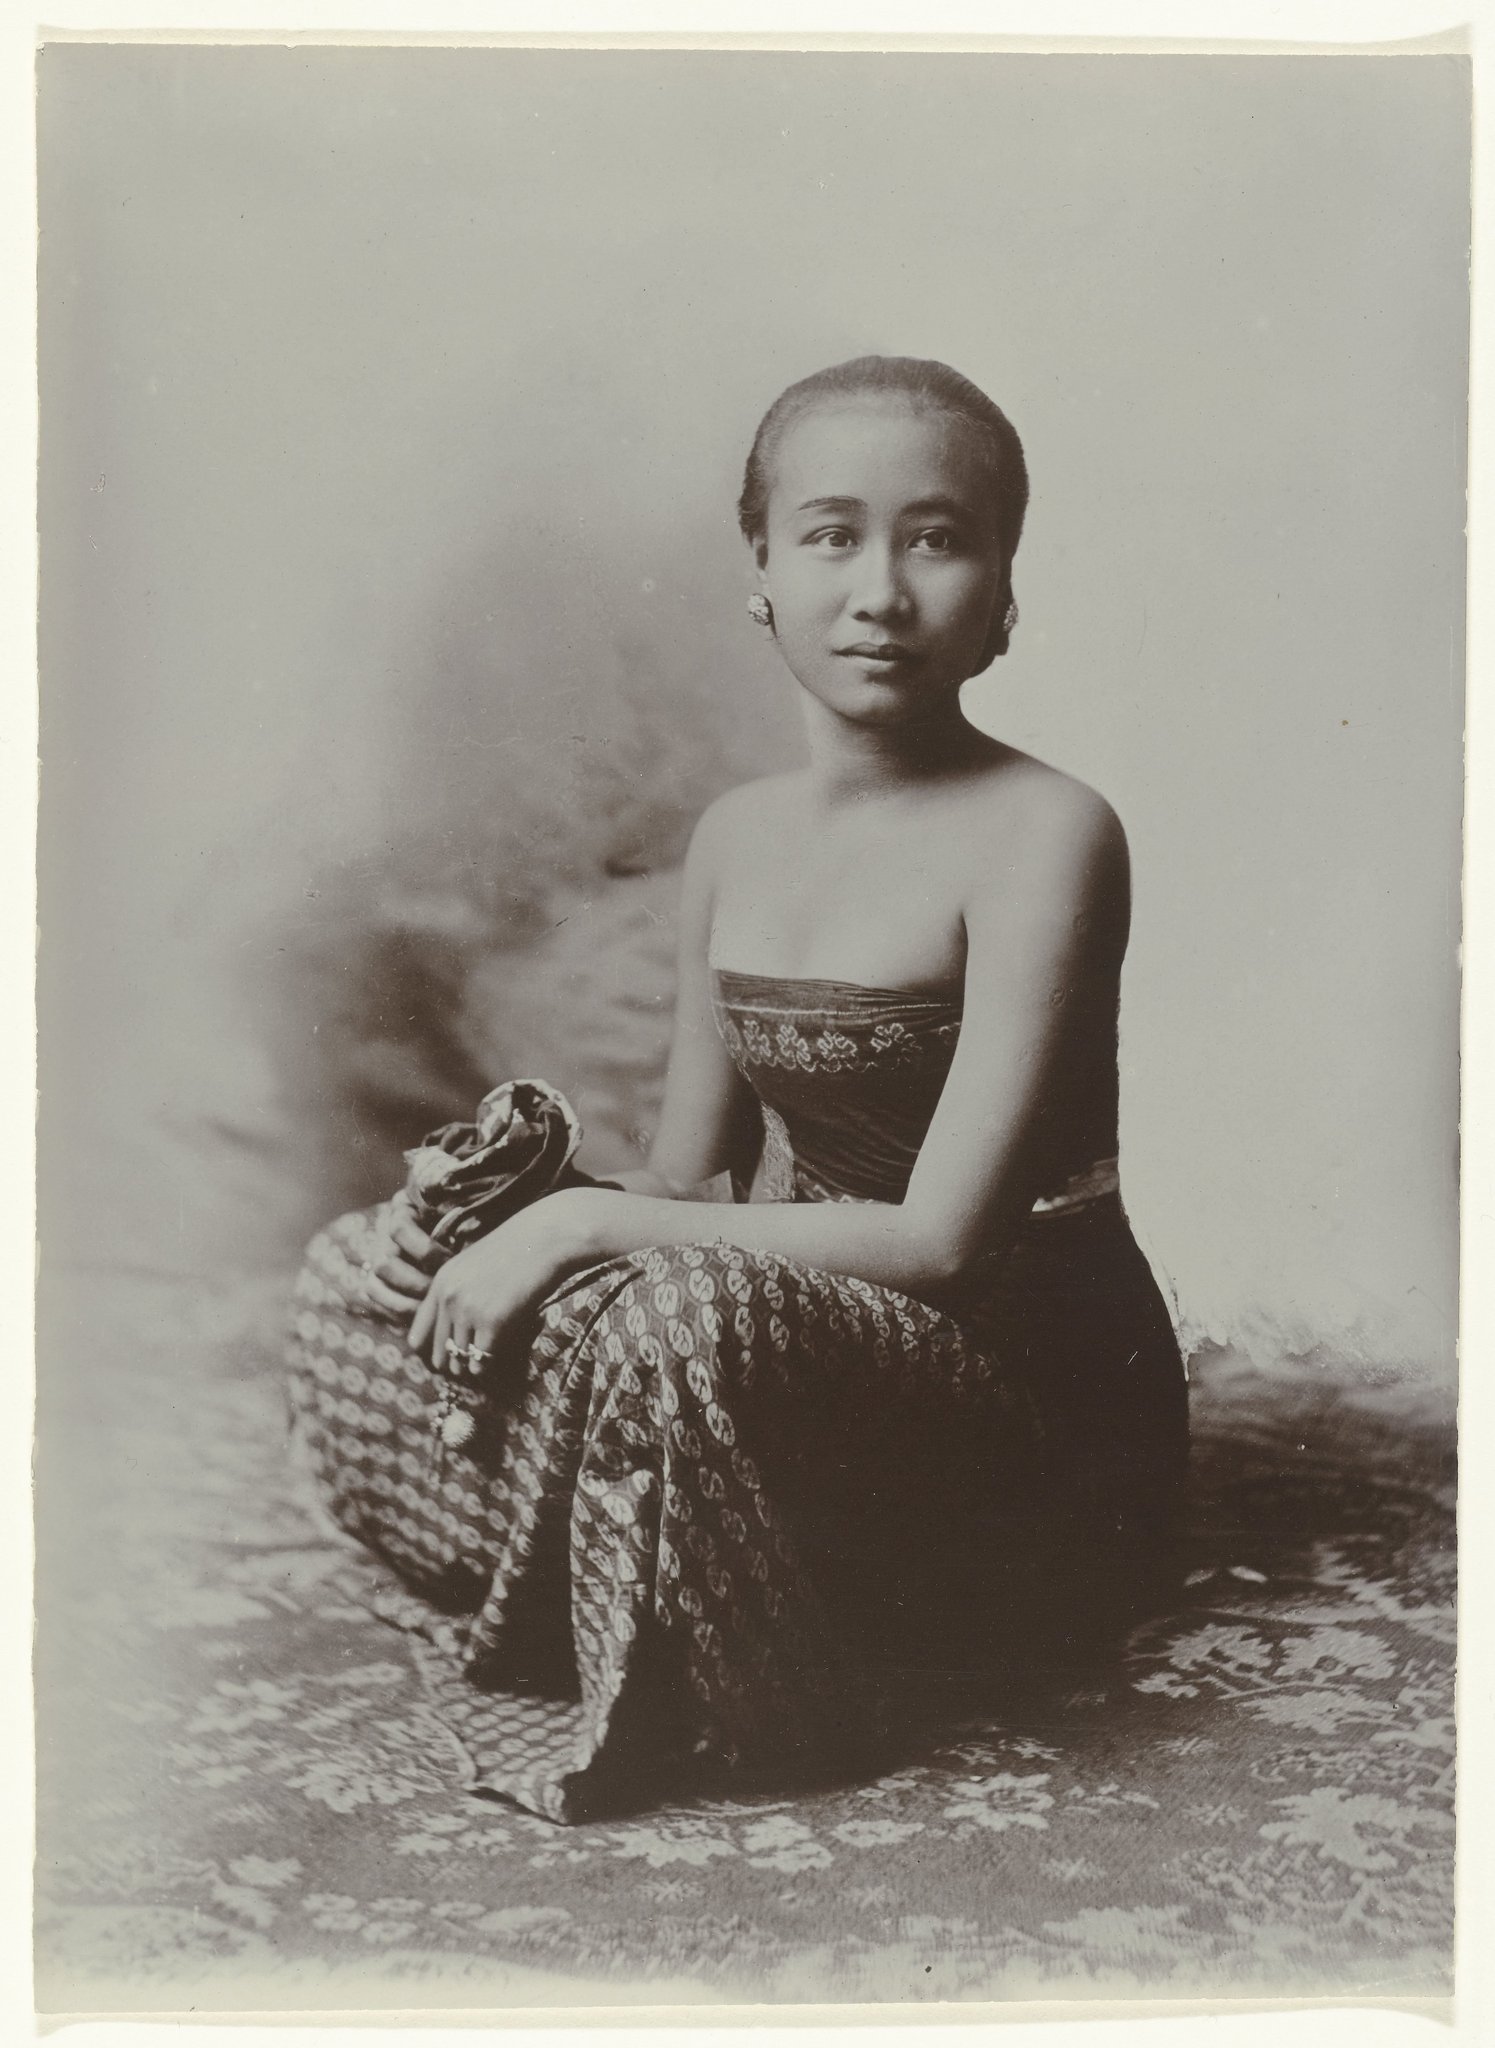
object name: photograph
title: Studioportret van een zittende jonge Javaanse vrouw in een sarong met batik motief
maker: kassian céphas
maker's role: fotograaf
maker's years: 1845-1912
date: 1867-1910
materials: cardboard, paper, photographic support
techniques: albumen print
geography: java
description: Studioportret van een zittende jonge Javaanse vrouw in een sarong met batik motief. De vrouw draagt sieraden in oren en aan handen.